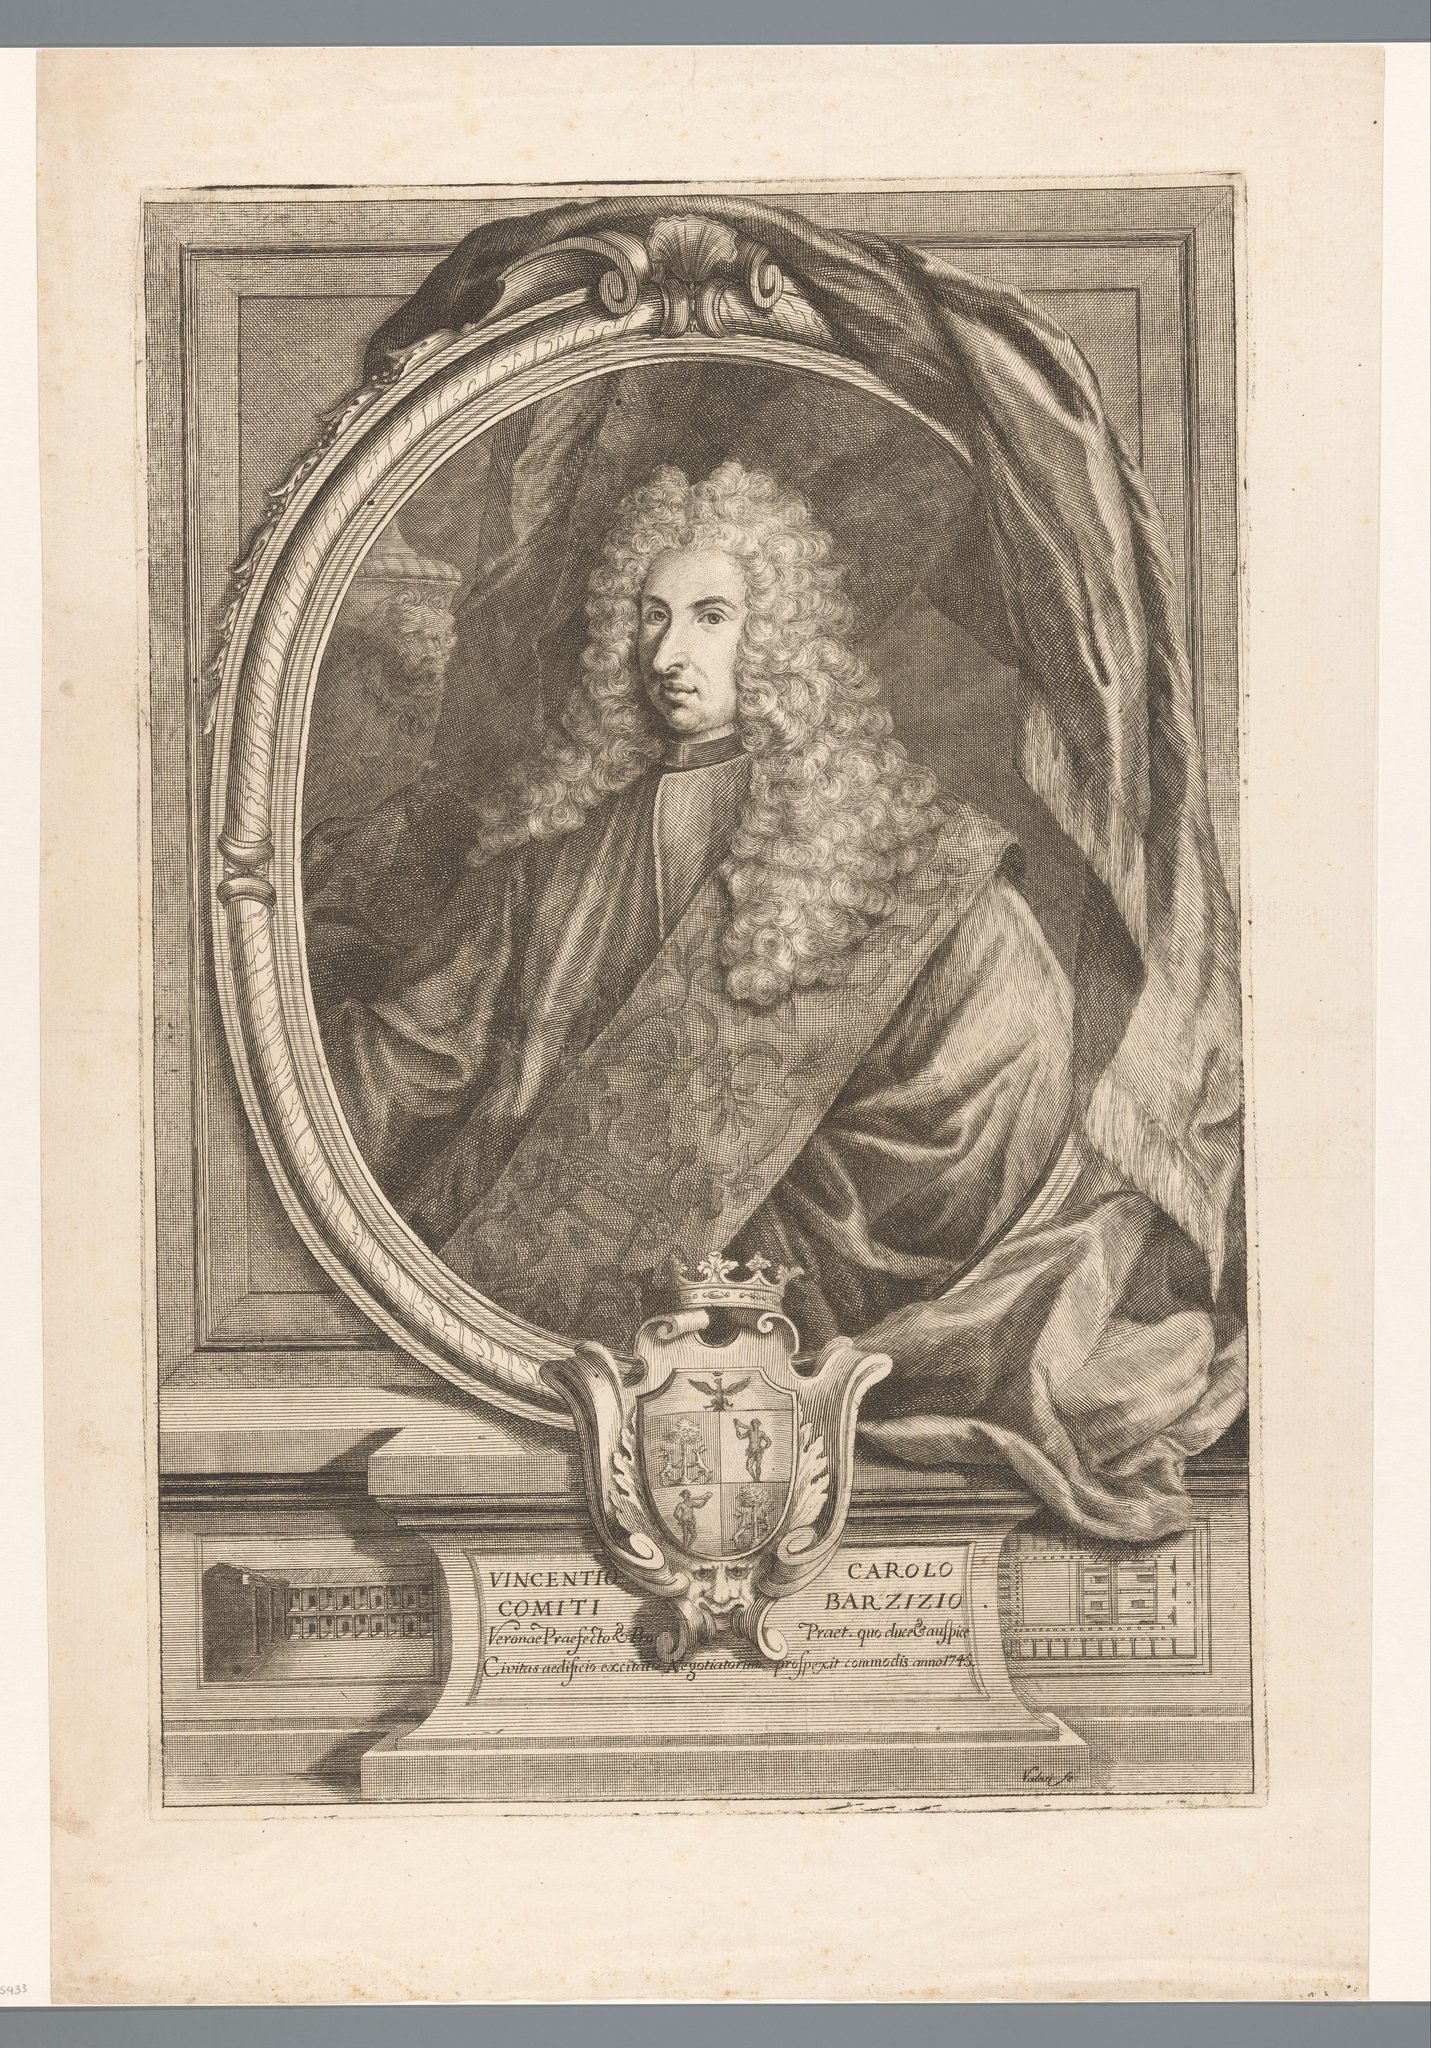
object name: print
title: Portret van Vincenzo Carlo Barzizza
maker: dionigi valesio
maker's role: painter, print maker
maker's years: 1730-1780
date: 1740-1780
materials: paper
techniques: engraving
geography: italy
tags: historical persons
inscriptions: collector's mark: Lugt 2228